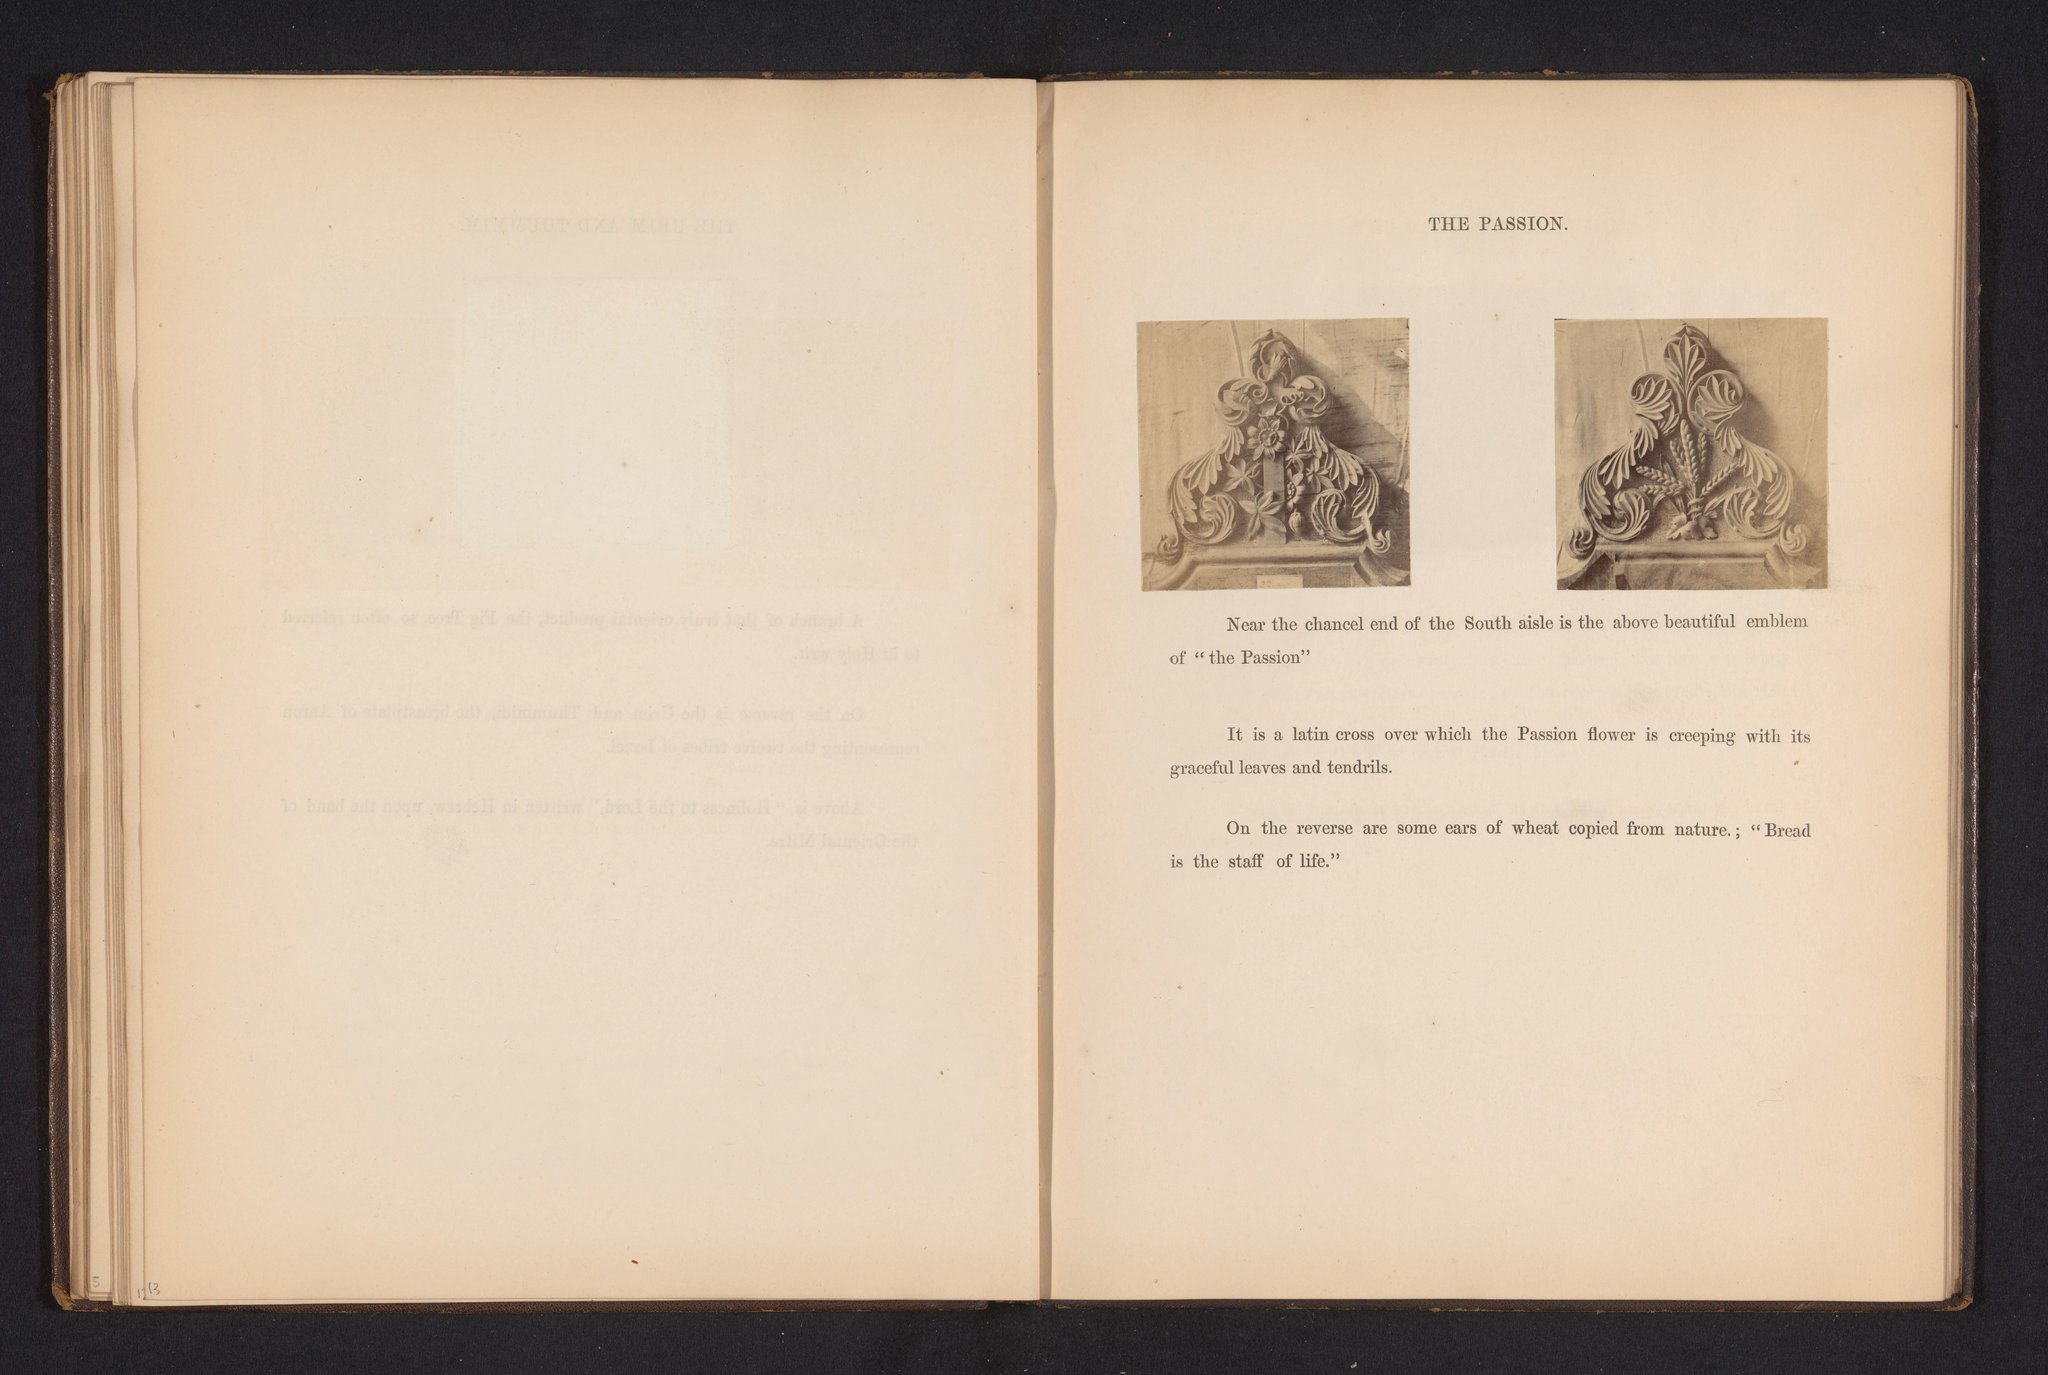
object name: page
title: The passion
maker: Anonymous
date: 1857-1867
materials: photographic support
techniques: albumen print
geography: st michael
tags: bench, ear of corn